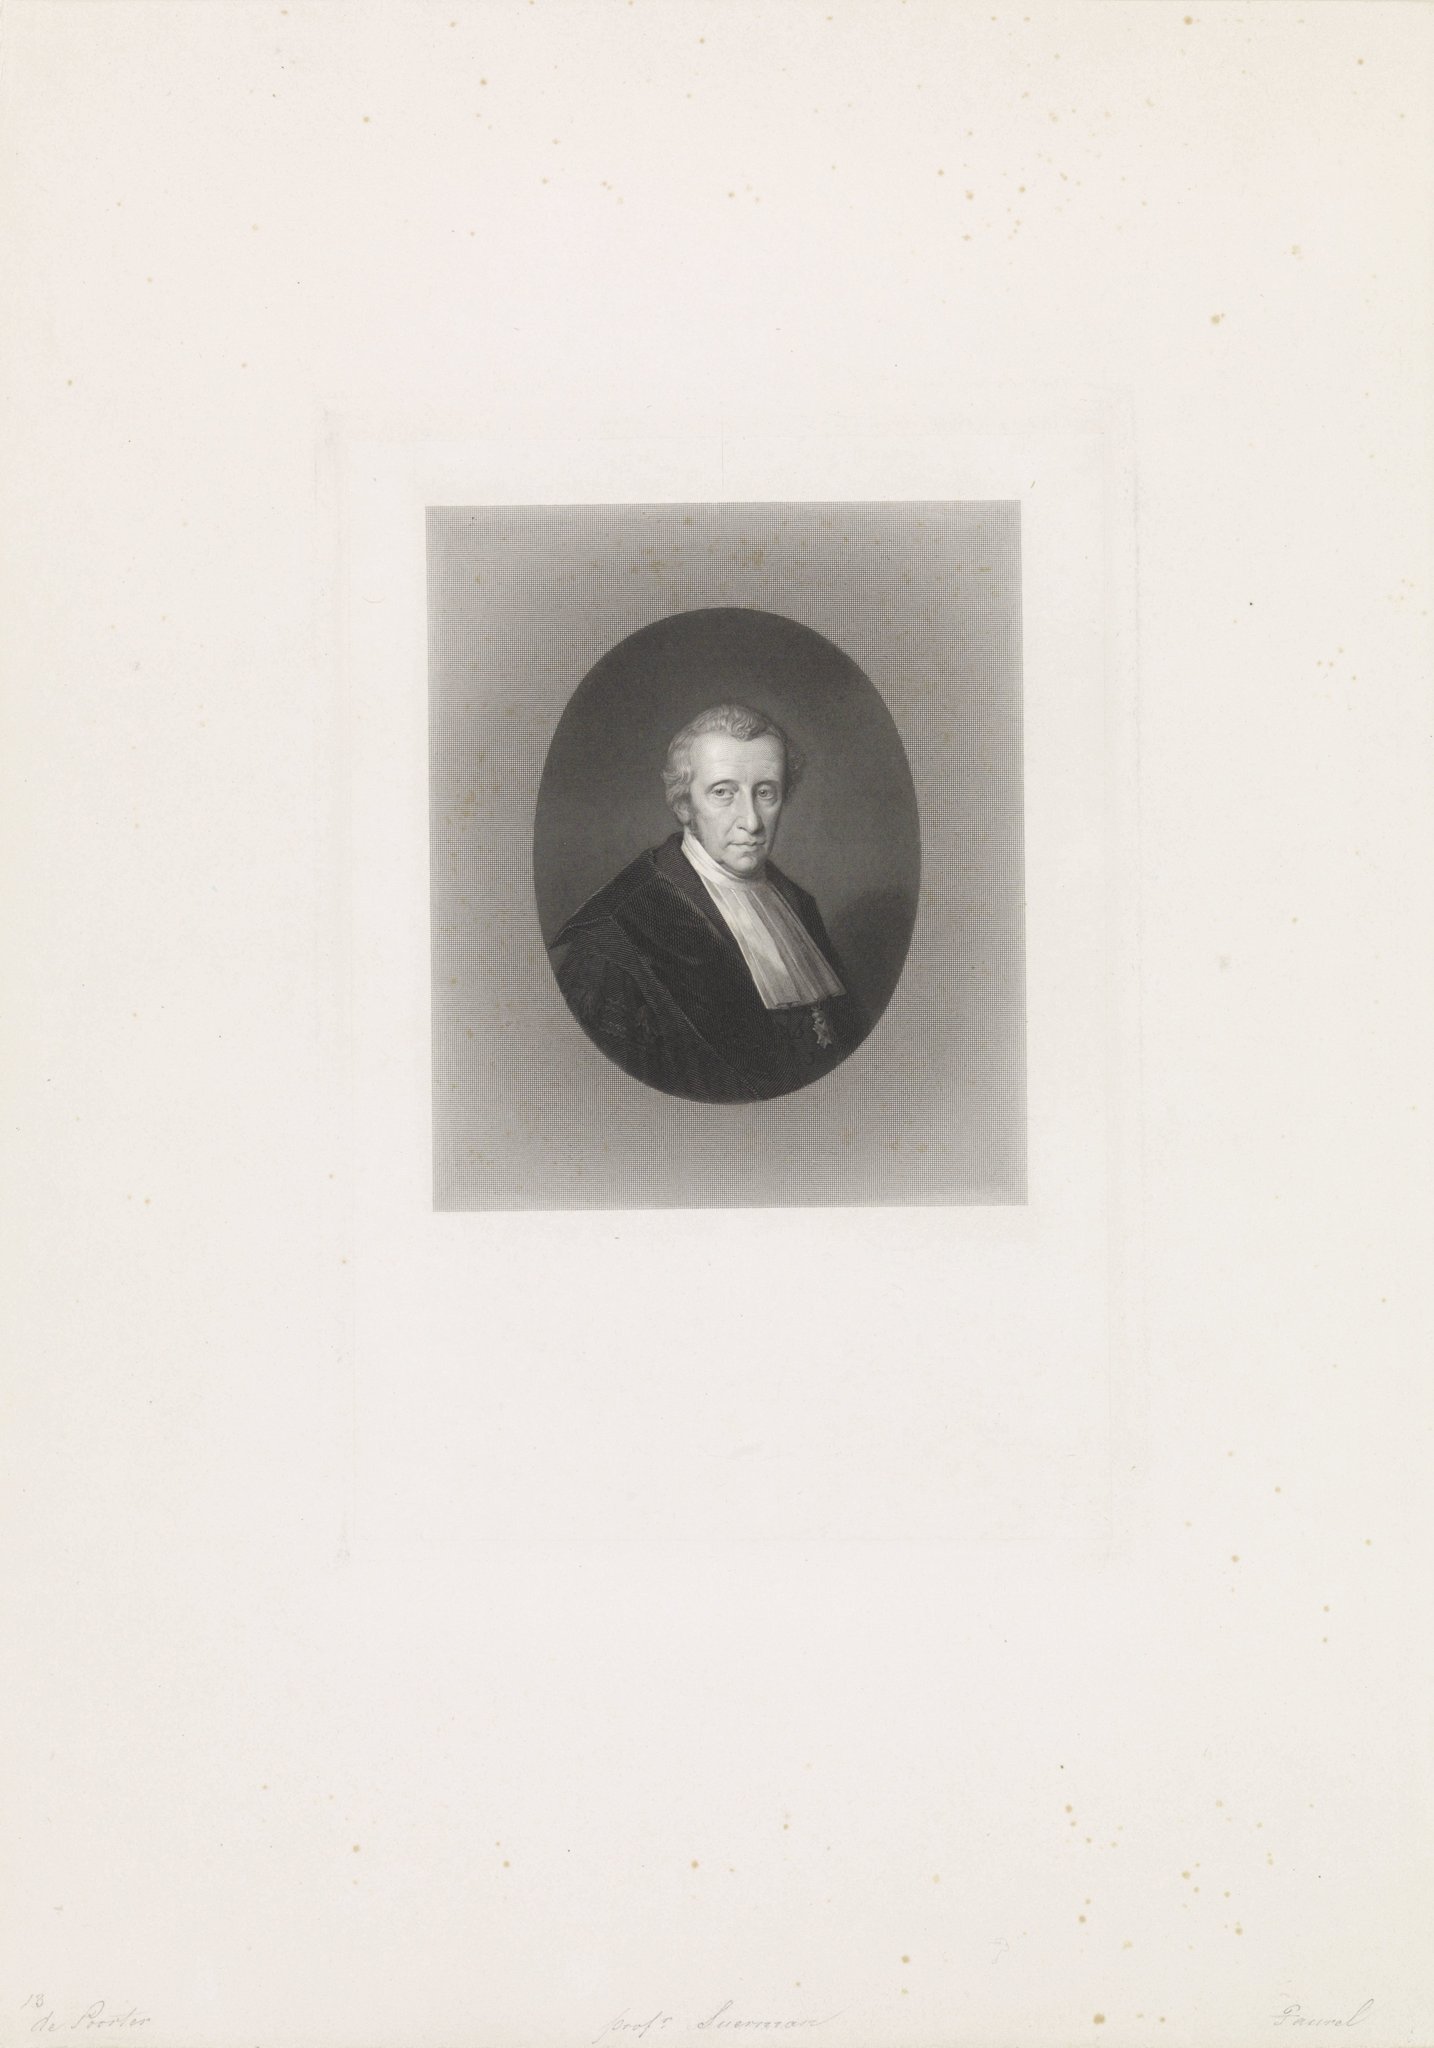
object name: print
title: Portret van de onderwijzer Bernardus Franciscus Suerman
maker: benoit taurel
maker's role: draughtsman, print maker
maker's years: 1794-1859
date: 1858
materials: paper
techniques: engraving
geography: amsterdam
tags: haarlem, utrecht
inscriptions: name: ‘de Poorter/ prof.Suerman/ Taurel’, collector's mark: Lugt 12